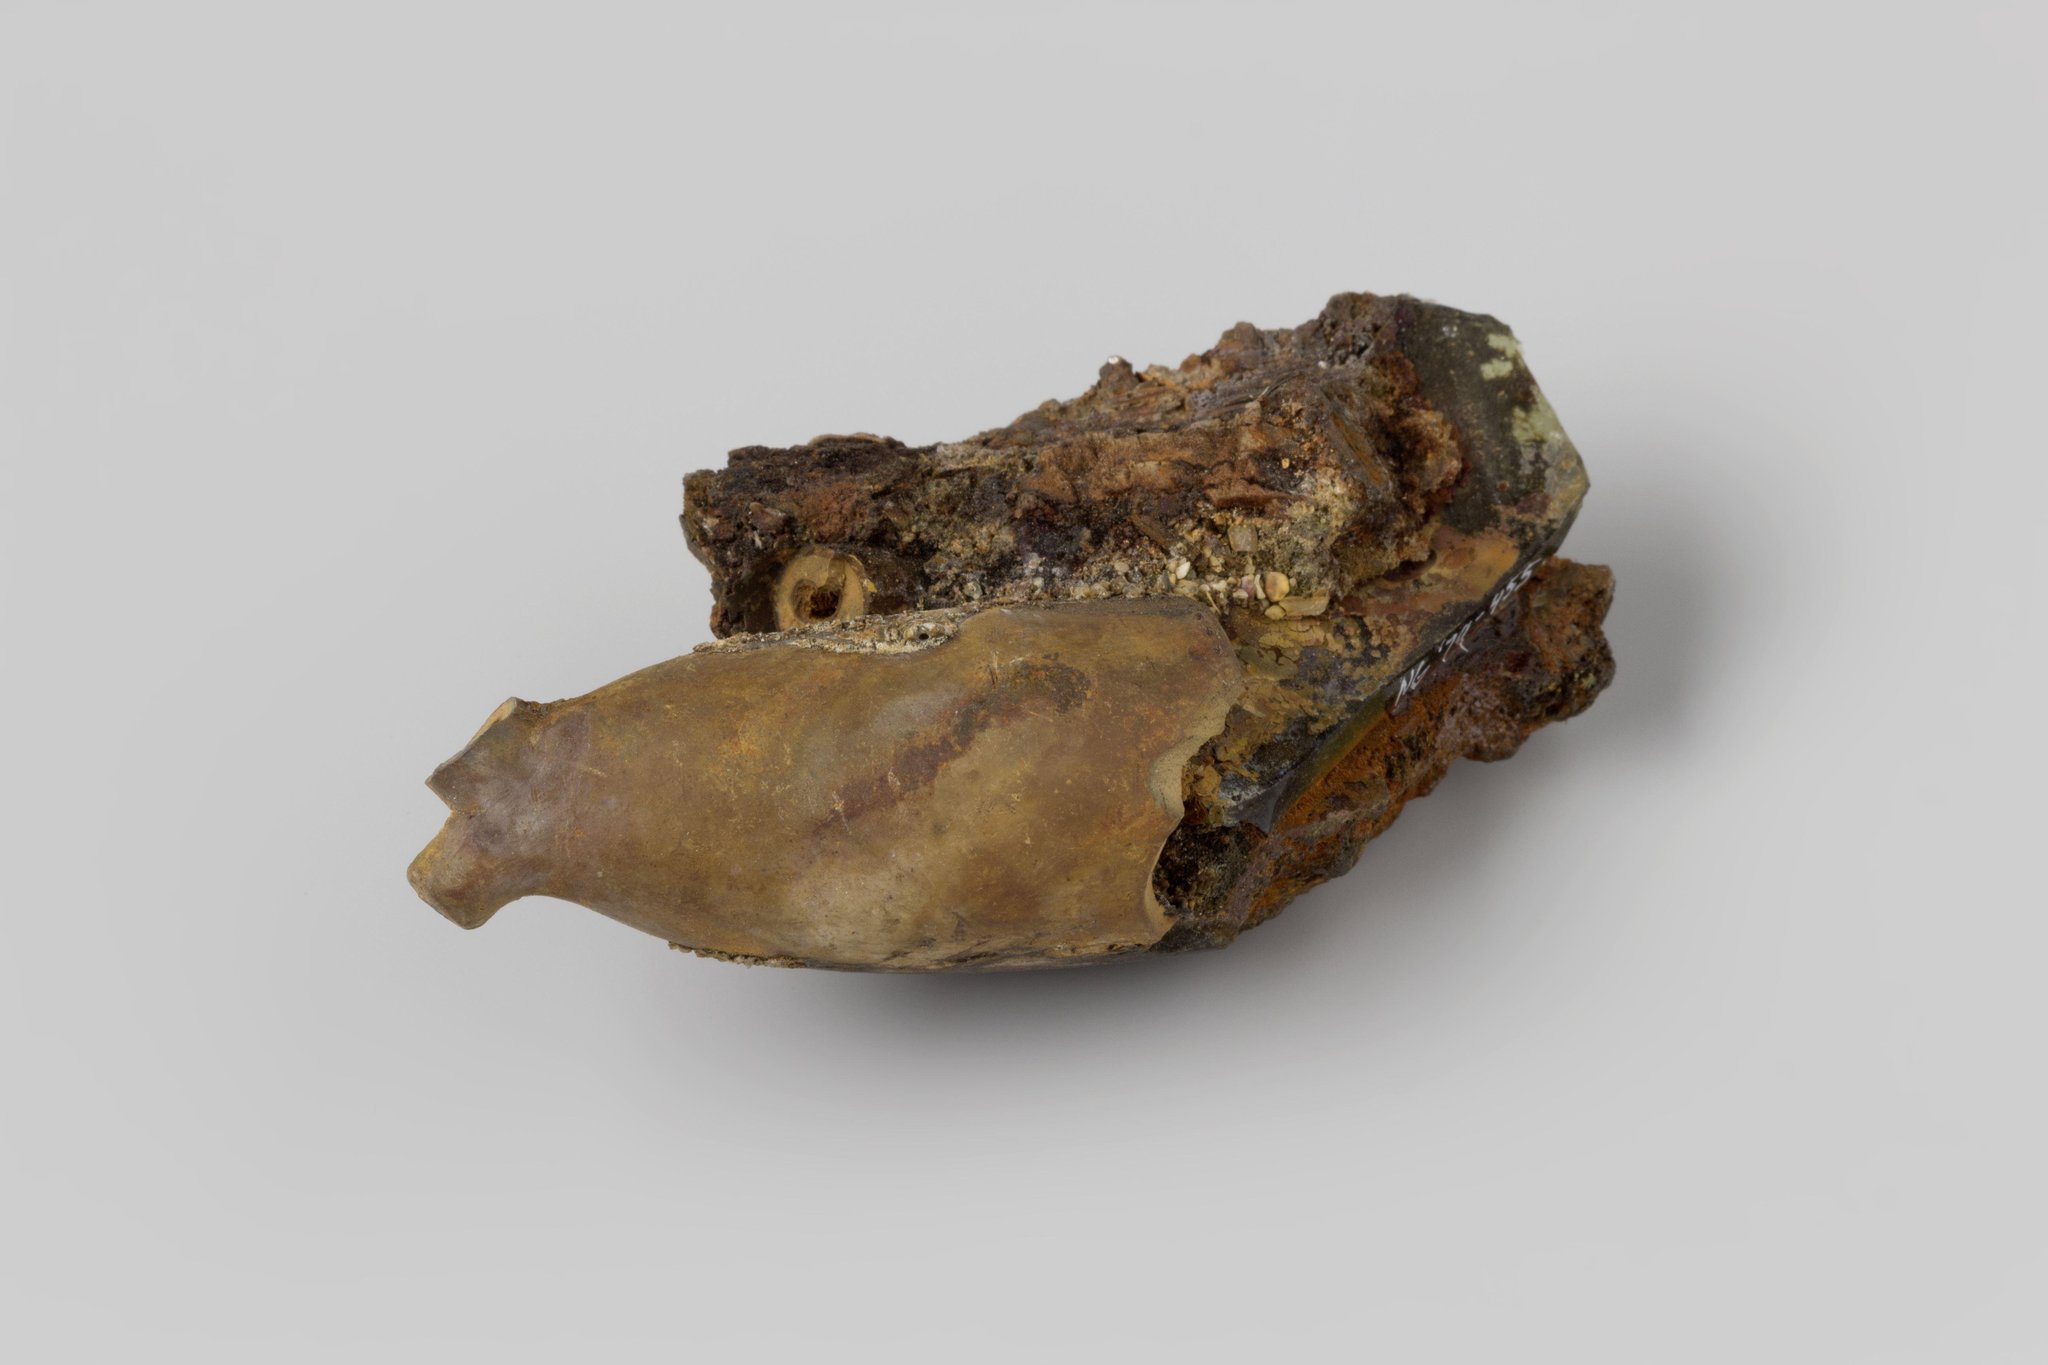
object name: pipe bowl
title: Concretie met fragment pijpenkop en glas uit het wrak van de Oost-Indiëvaarder Hollandia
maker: Anonymous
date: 1700-1743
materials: stone, glass, clay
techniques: green glass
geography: netherlands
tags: verenigde oostindische compagnie, hollandia (schip), annet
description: Pipe, bowl, heelmark: arched cage; fragment, no hsm.